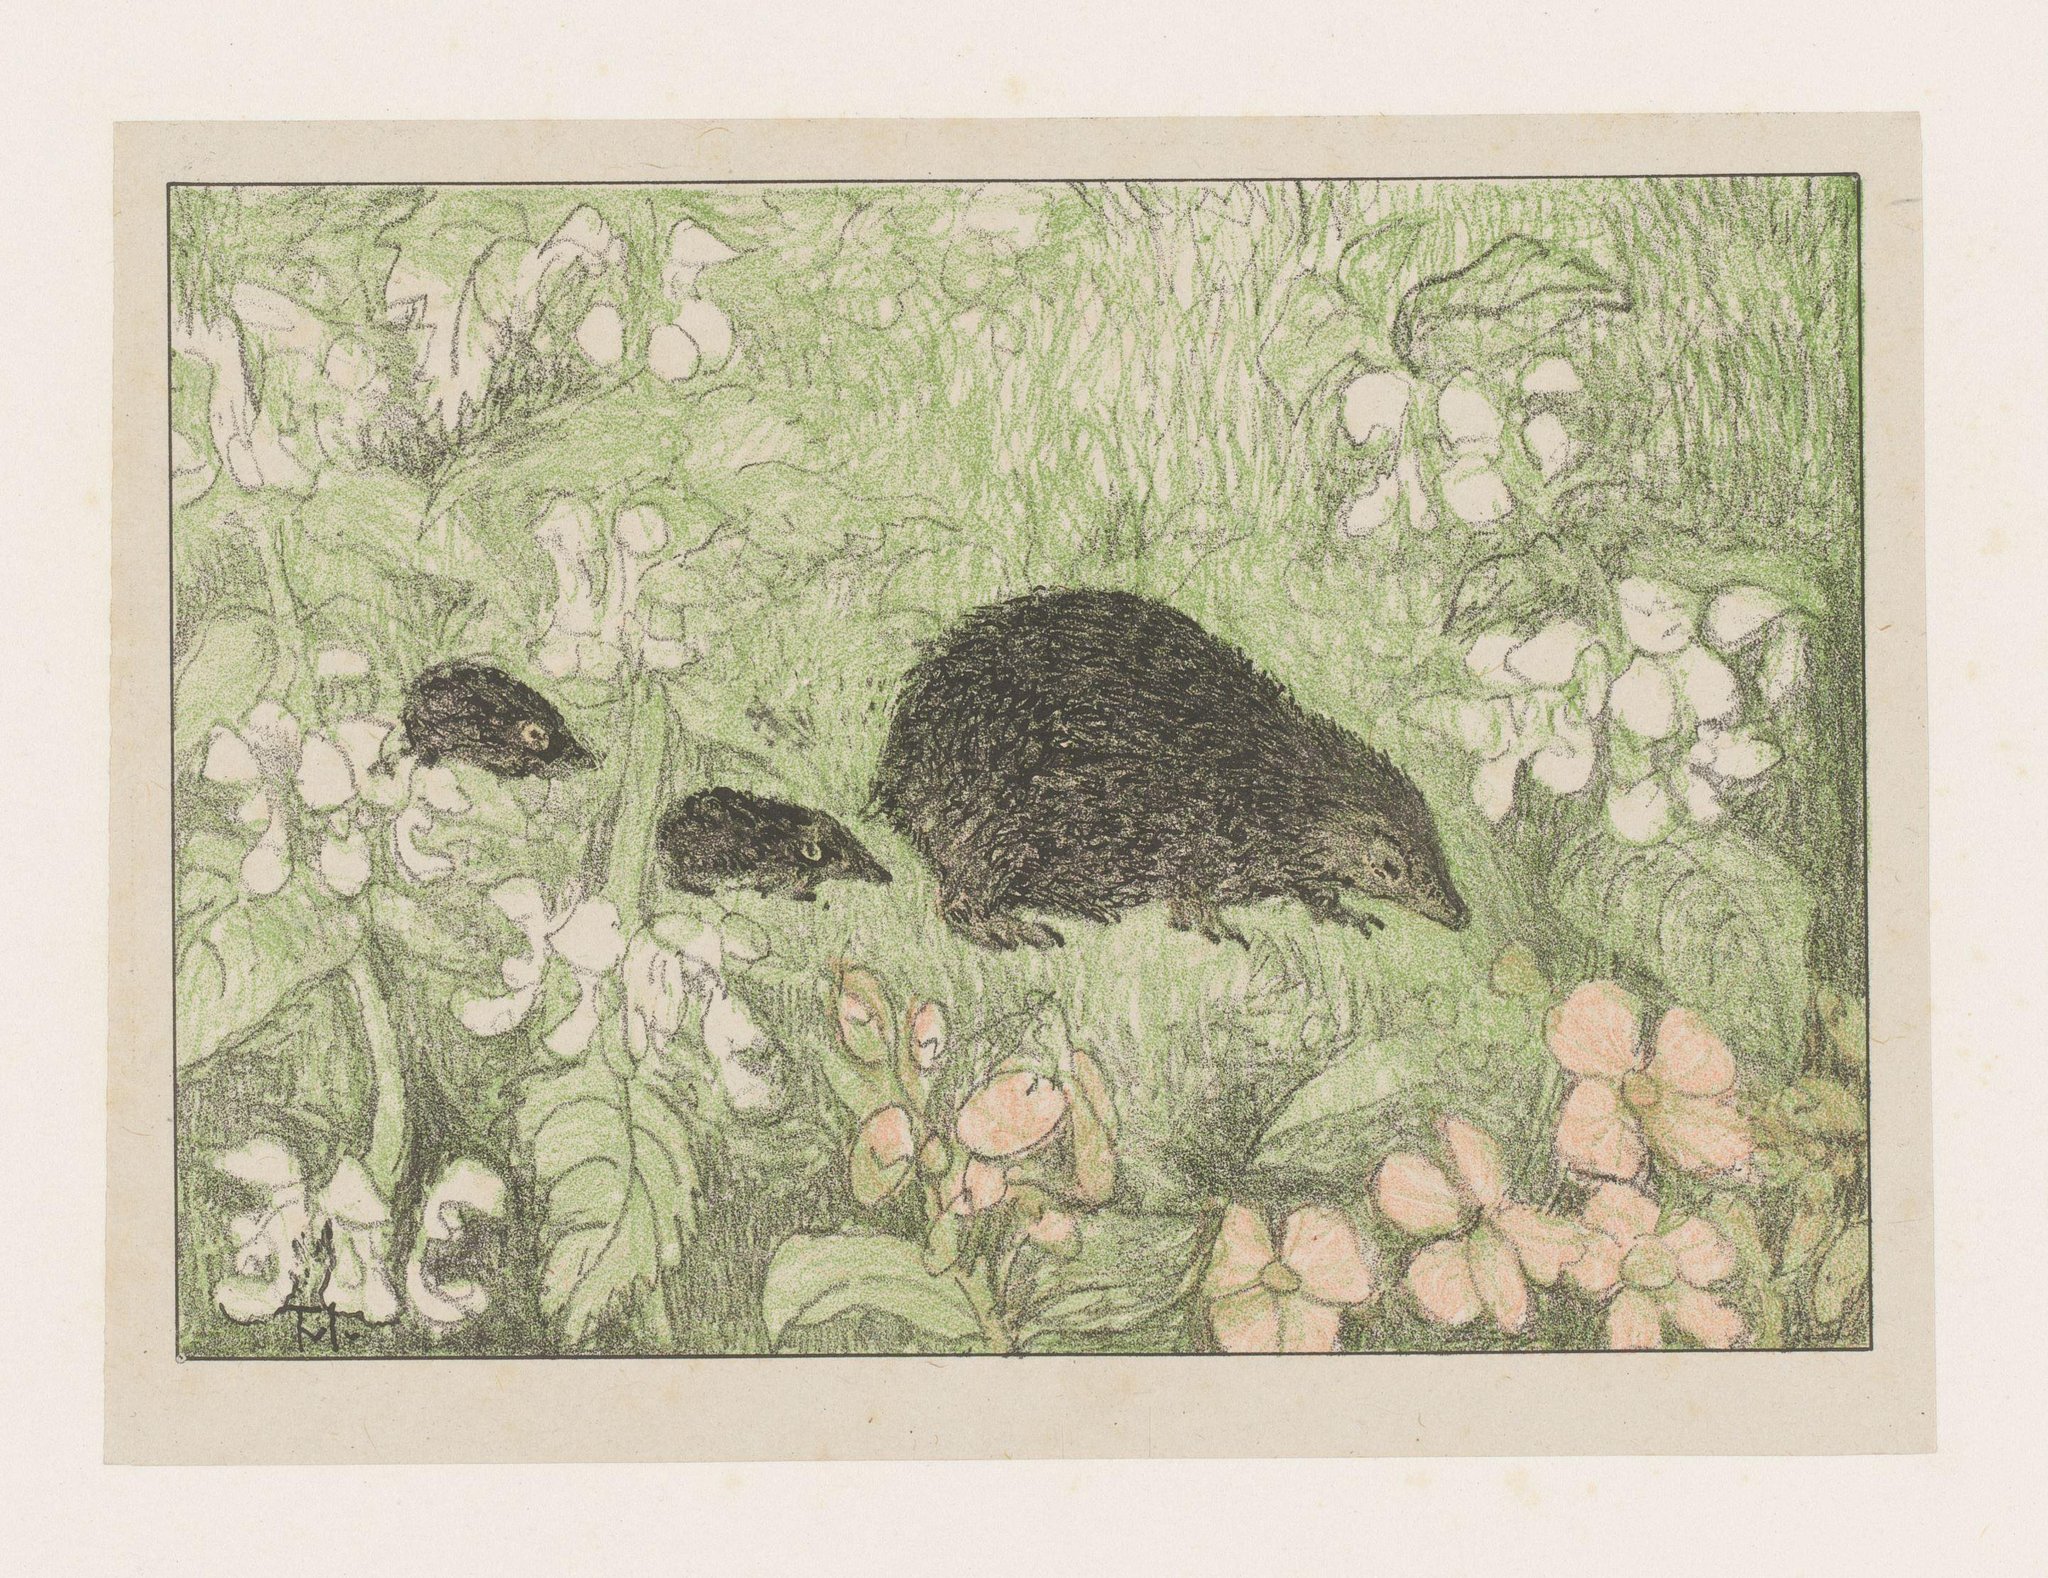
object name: print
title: Egel met jongen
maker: theo van hoytema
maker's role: draughtsman, painter, print maker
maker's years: 1863-1917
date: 1878-1914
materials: paper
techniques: lithograph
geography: texel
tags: other mammals: hedgehog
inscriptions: collector's mark: Lugt 2228, collector's mark: Lugt 4731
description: Prent is een proefdruk voor kalenderblad juni 1914.